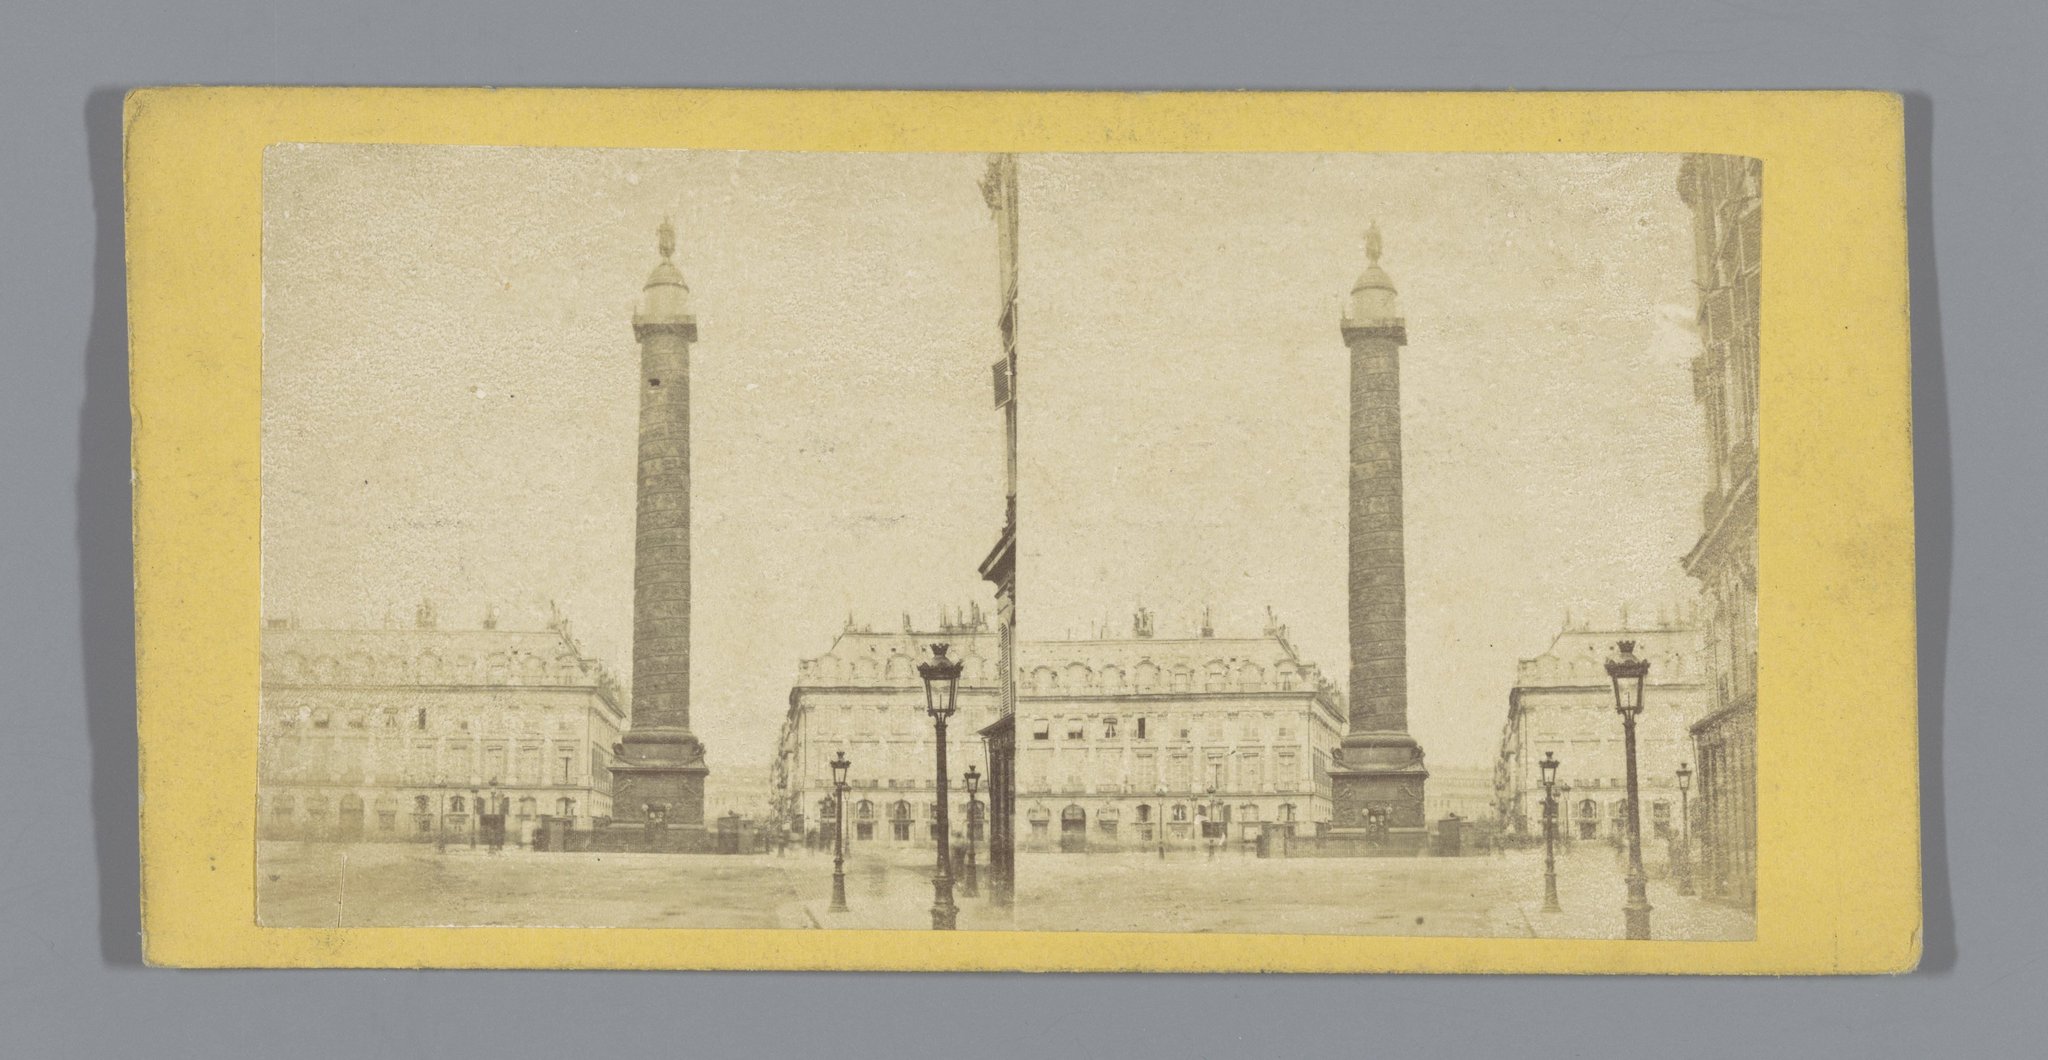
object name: stereograph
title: Colonne Vendôme te Parijs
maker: Anonymous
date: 1850-1875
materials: cardboard, photographic support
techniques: albumen print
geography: place vendôme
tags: triumphal column with helical friezes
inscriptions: inscription: ‘Colonne Vendôme’